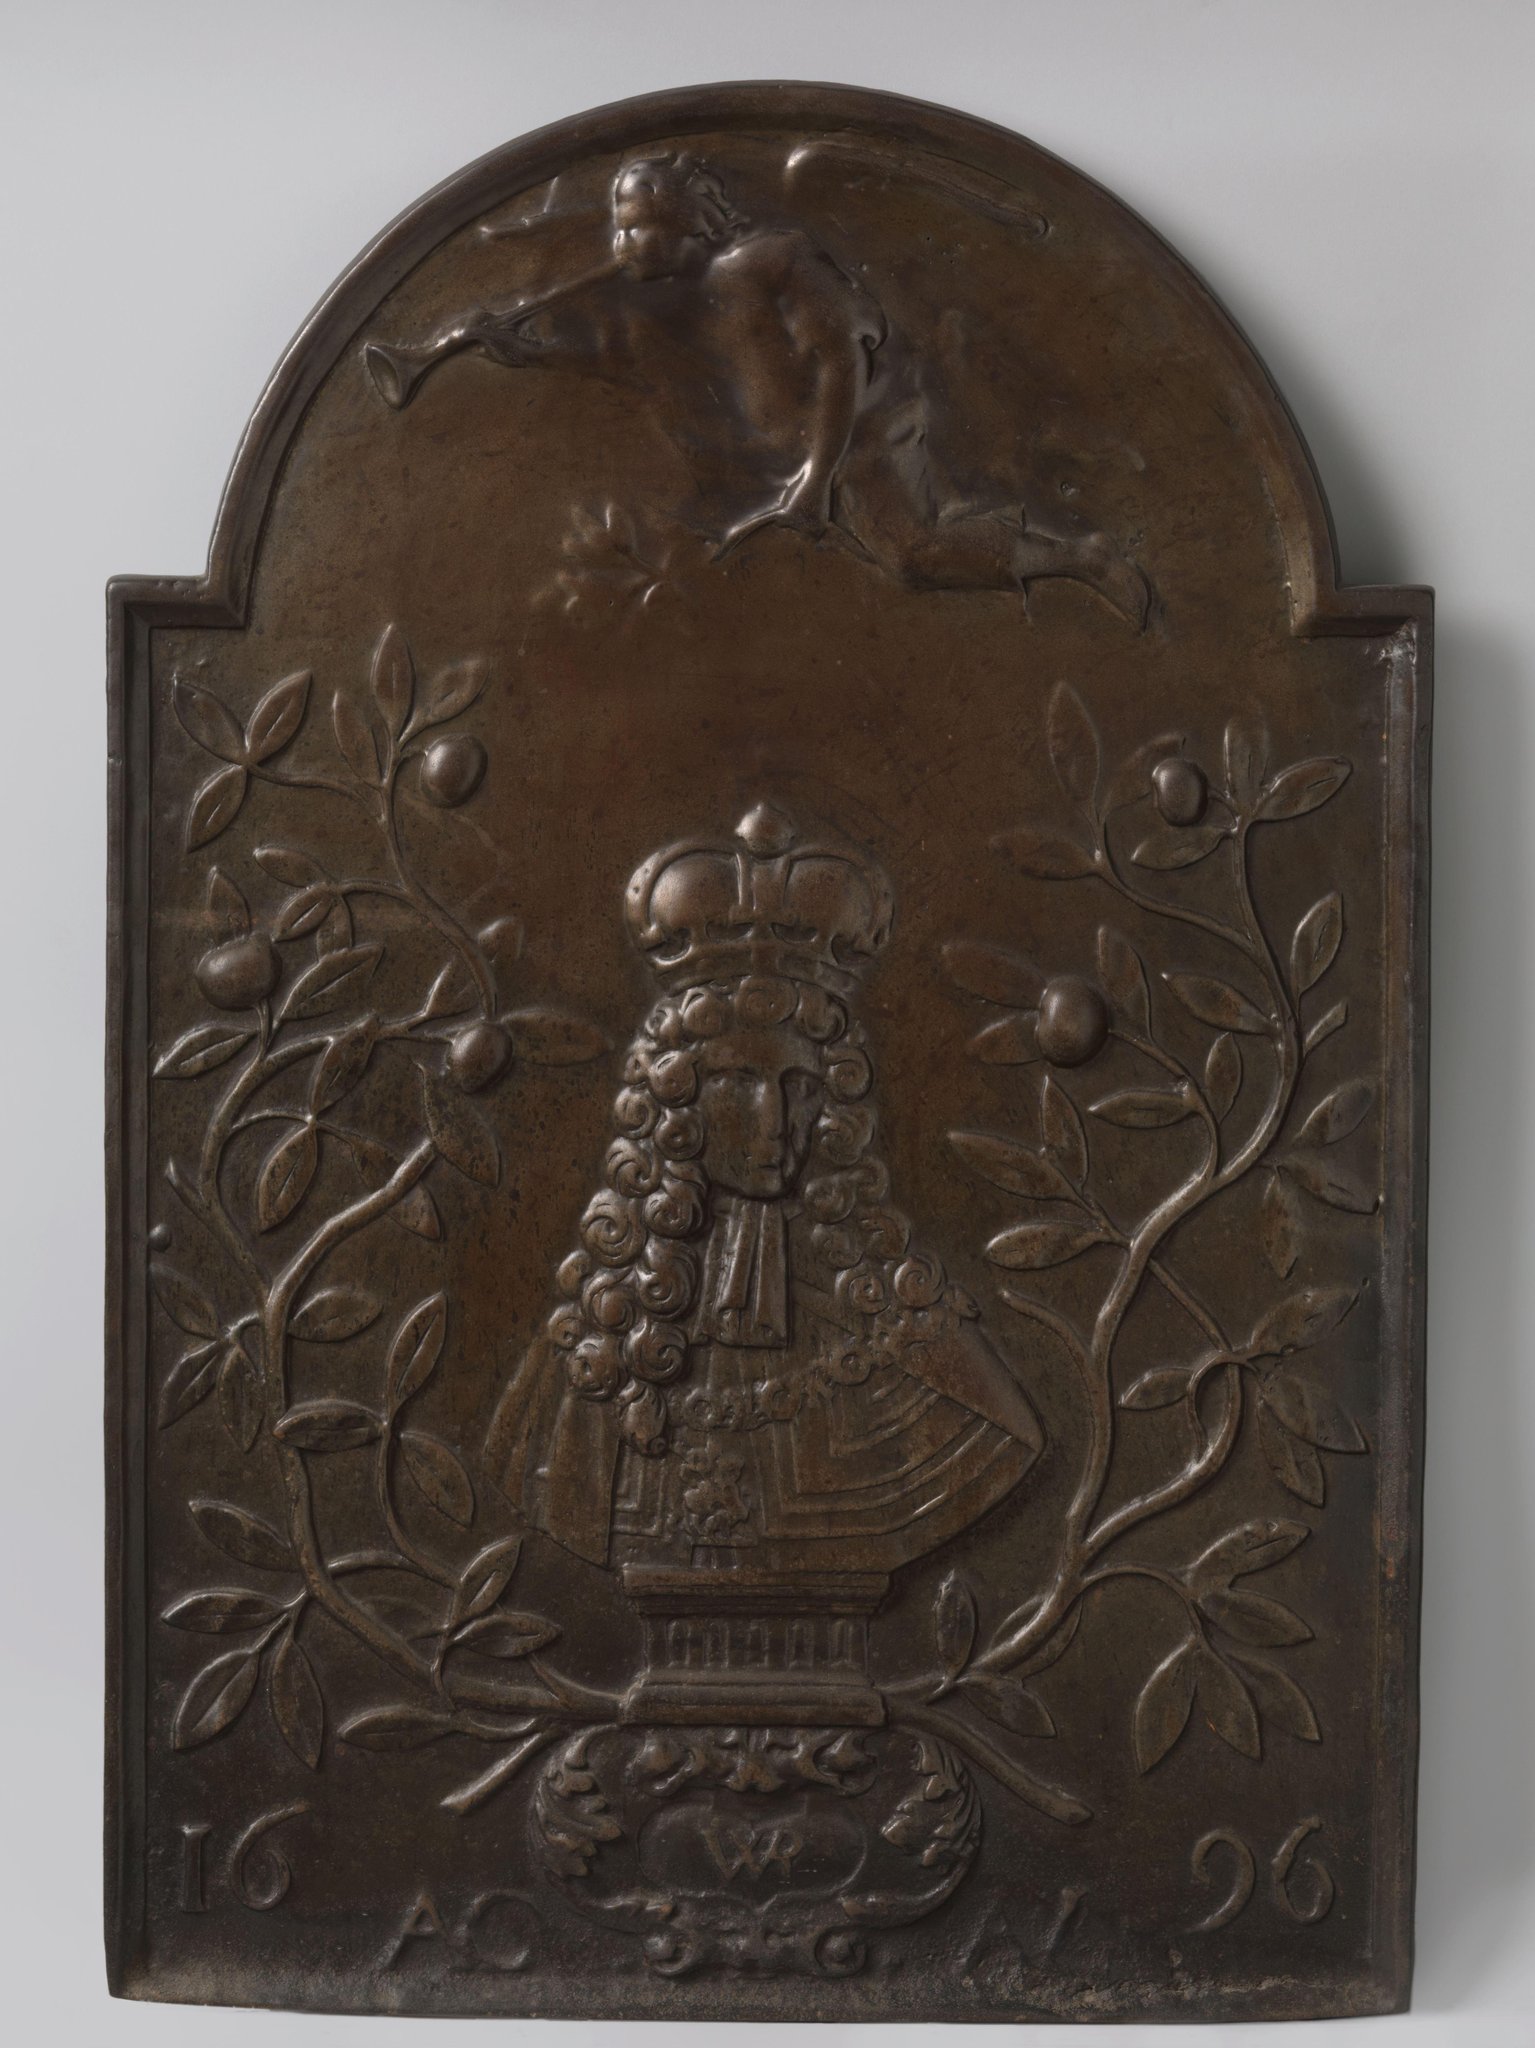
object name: fireback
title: Haardplaat met Willem III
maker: Anonymous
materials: iron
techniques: casting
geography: low countries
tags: the hague, william iii (prince of orange and king of england, scotland, and ireland)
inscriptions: inscription: ‘WR’, inscription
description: Haardplaat van gietijzer, met een halfronde bovenzijde. Centraal staat op een console de buste van stadhouder Willem III, koning van Engeland. Vanuit de console ontspringen aan weerszijden takken met oranjeappels. Op de console een cartouche met de initialen WR. Boven de buste vliegt Faam, blazend op een trompet en met een tak in de andere hand. Naast de console het jaartal 1696 en de initialen AG A[...]